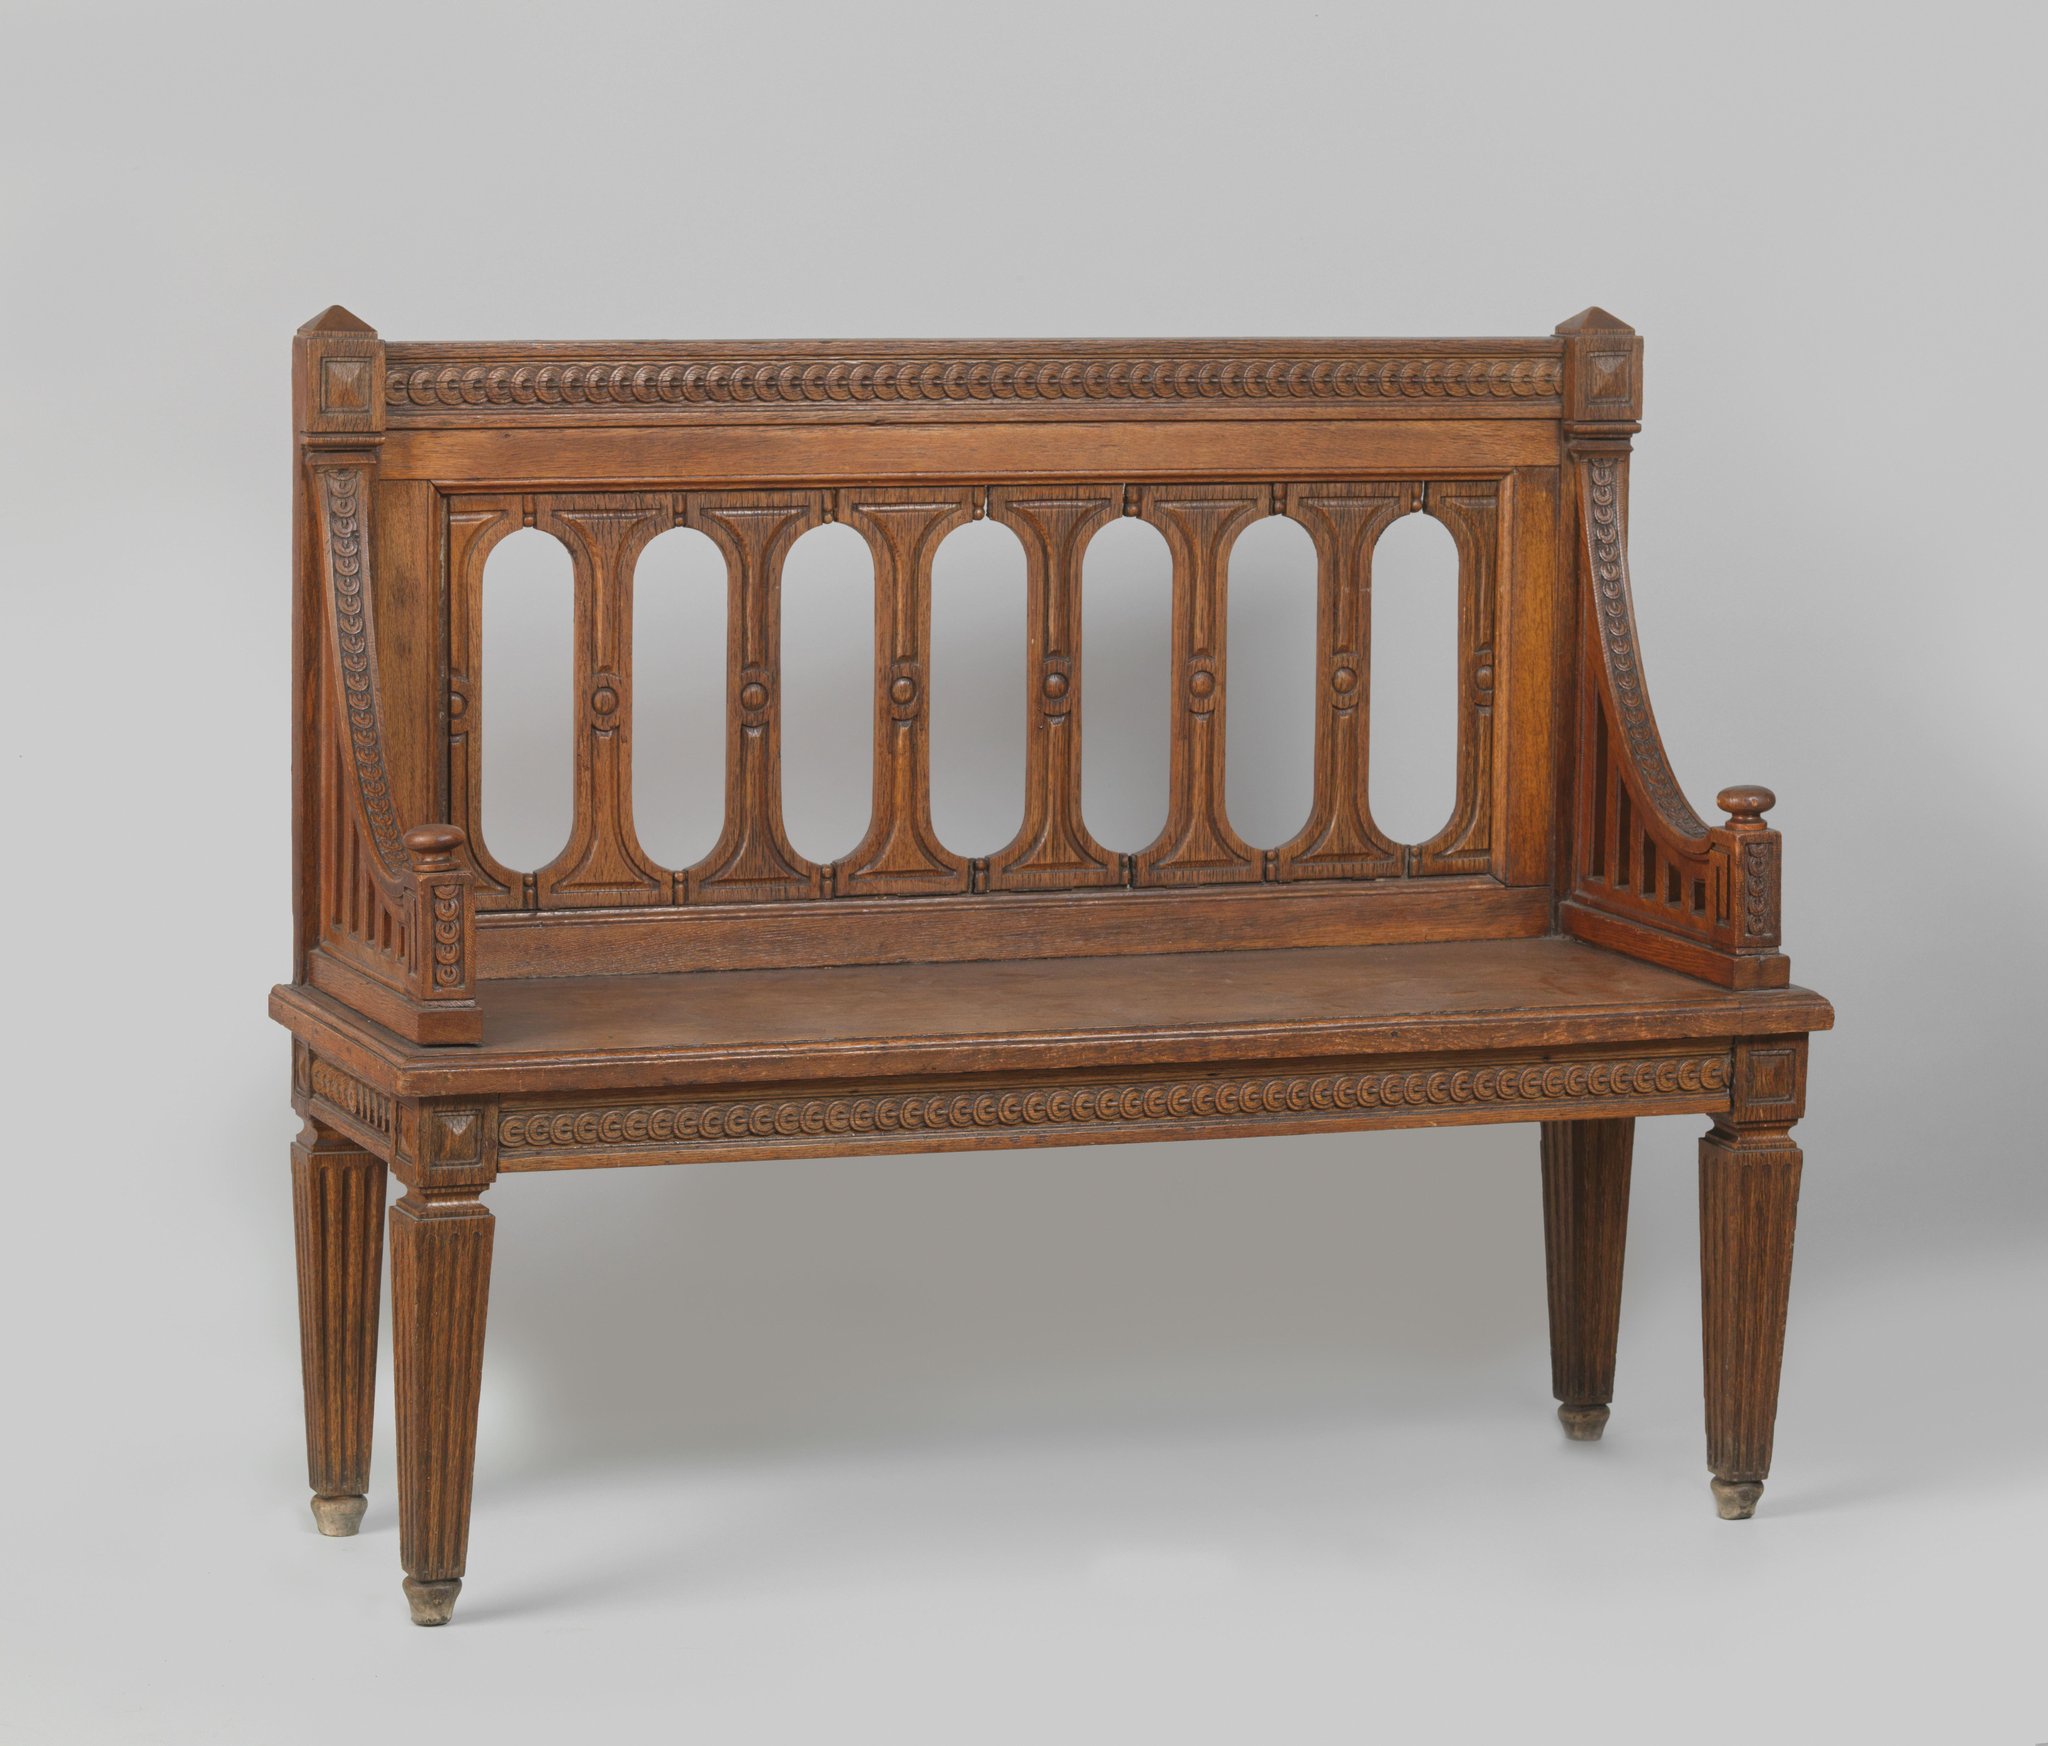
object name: sofa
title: Bank, versierd met ellipsvormen en snoeren.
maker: Anonymous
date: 1780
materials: wood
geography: northern netherlands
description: Bank van eikenhout met een opengewerkte rug met ellipsvormige openingen en armleuningen. De conische poten zijn gecanneleerd. De zitregels, armleuningen en rugleuning zijn versierd met snoeren.